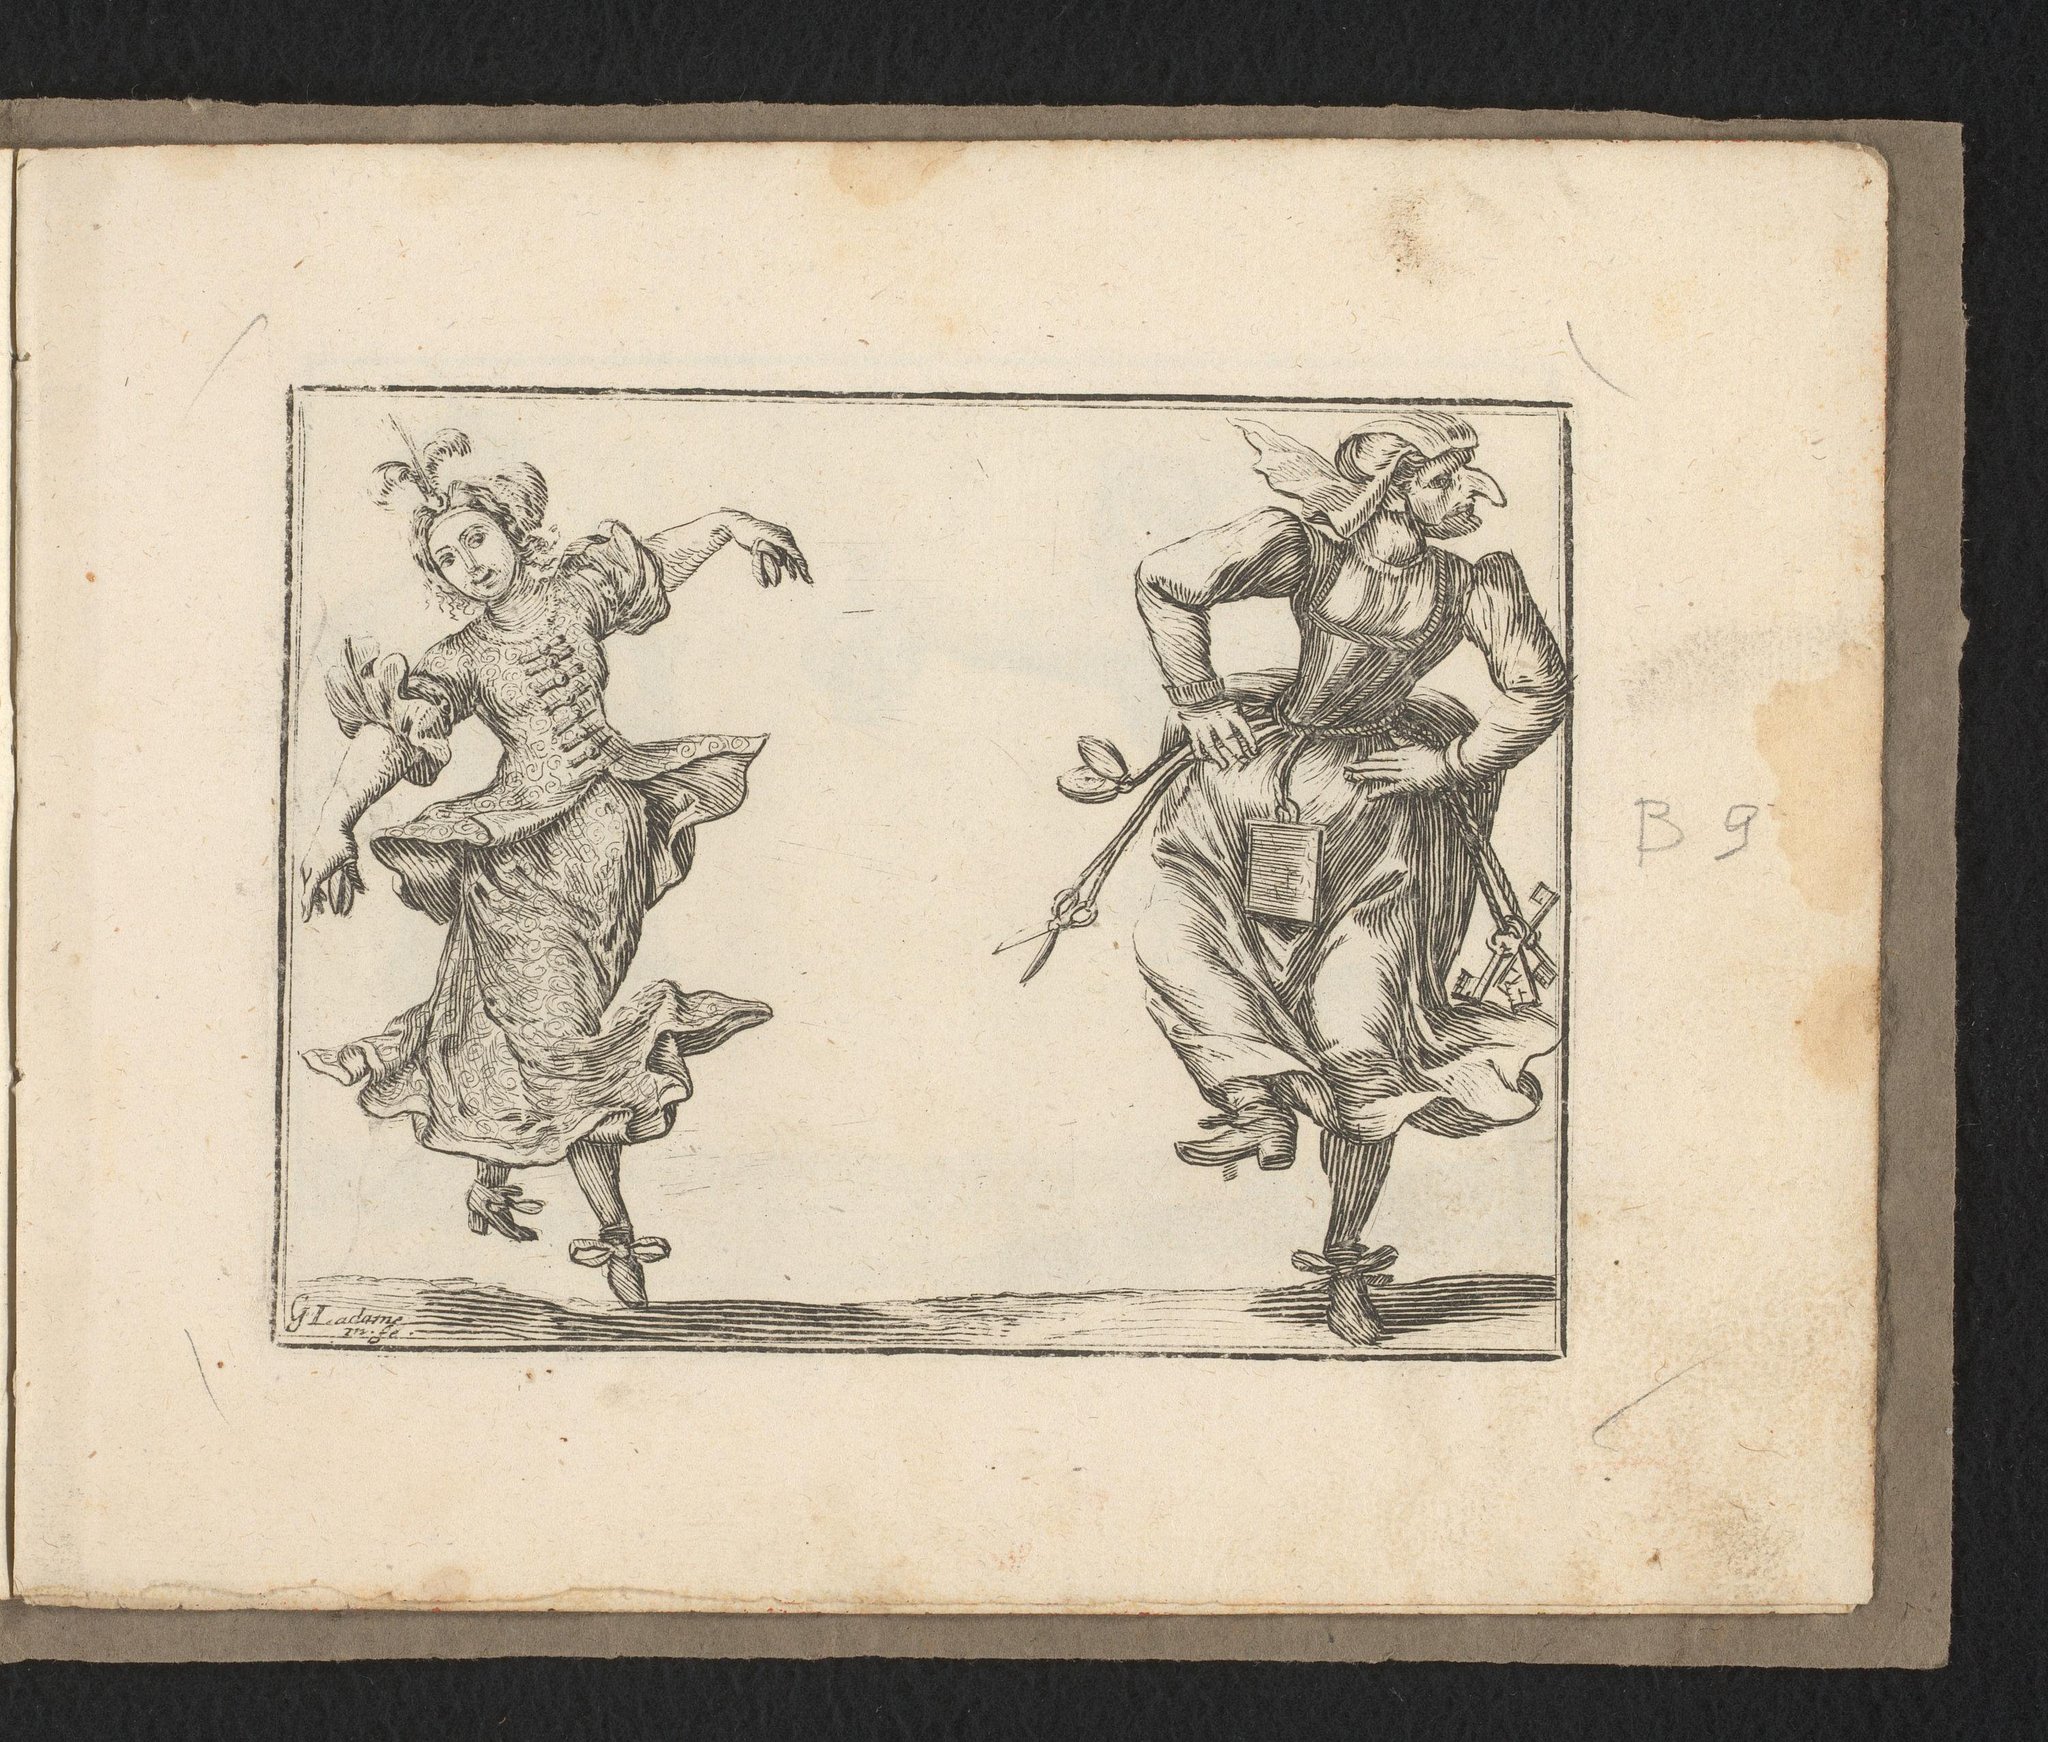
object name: print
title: Diverses figures a la mode propre et utile pour apprandre a la ieunesse a dessiner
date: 1660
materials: paper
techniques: etching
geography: paris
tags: woman dancing alone, upper ten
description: Deze prent maakt deel uit van een album.